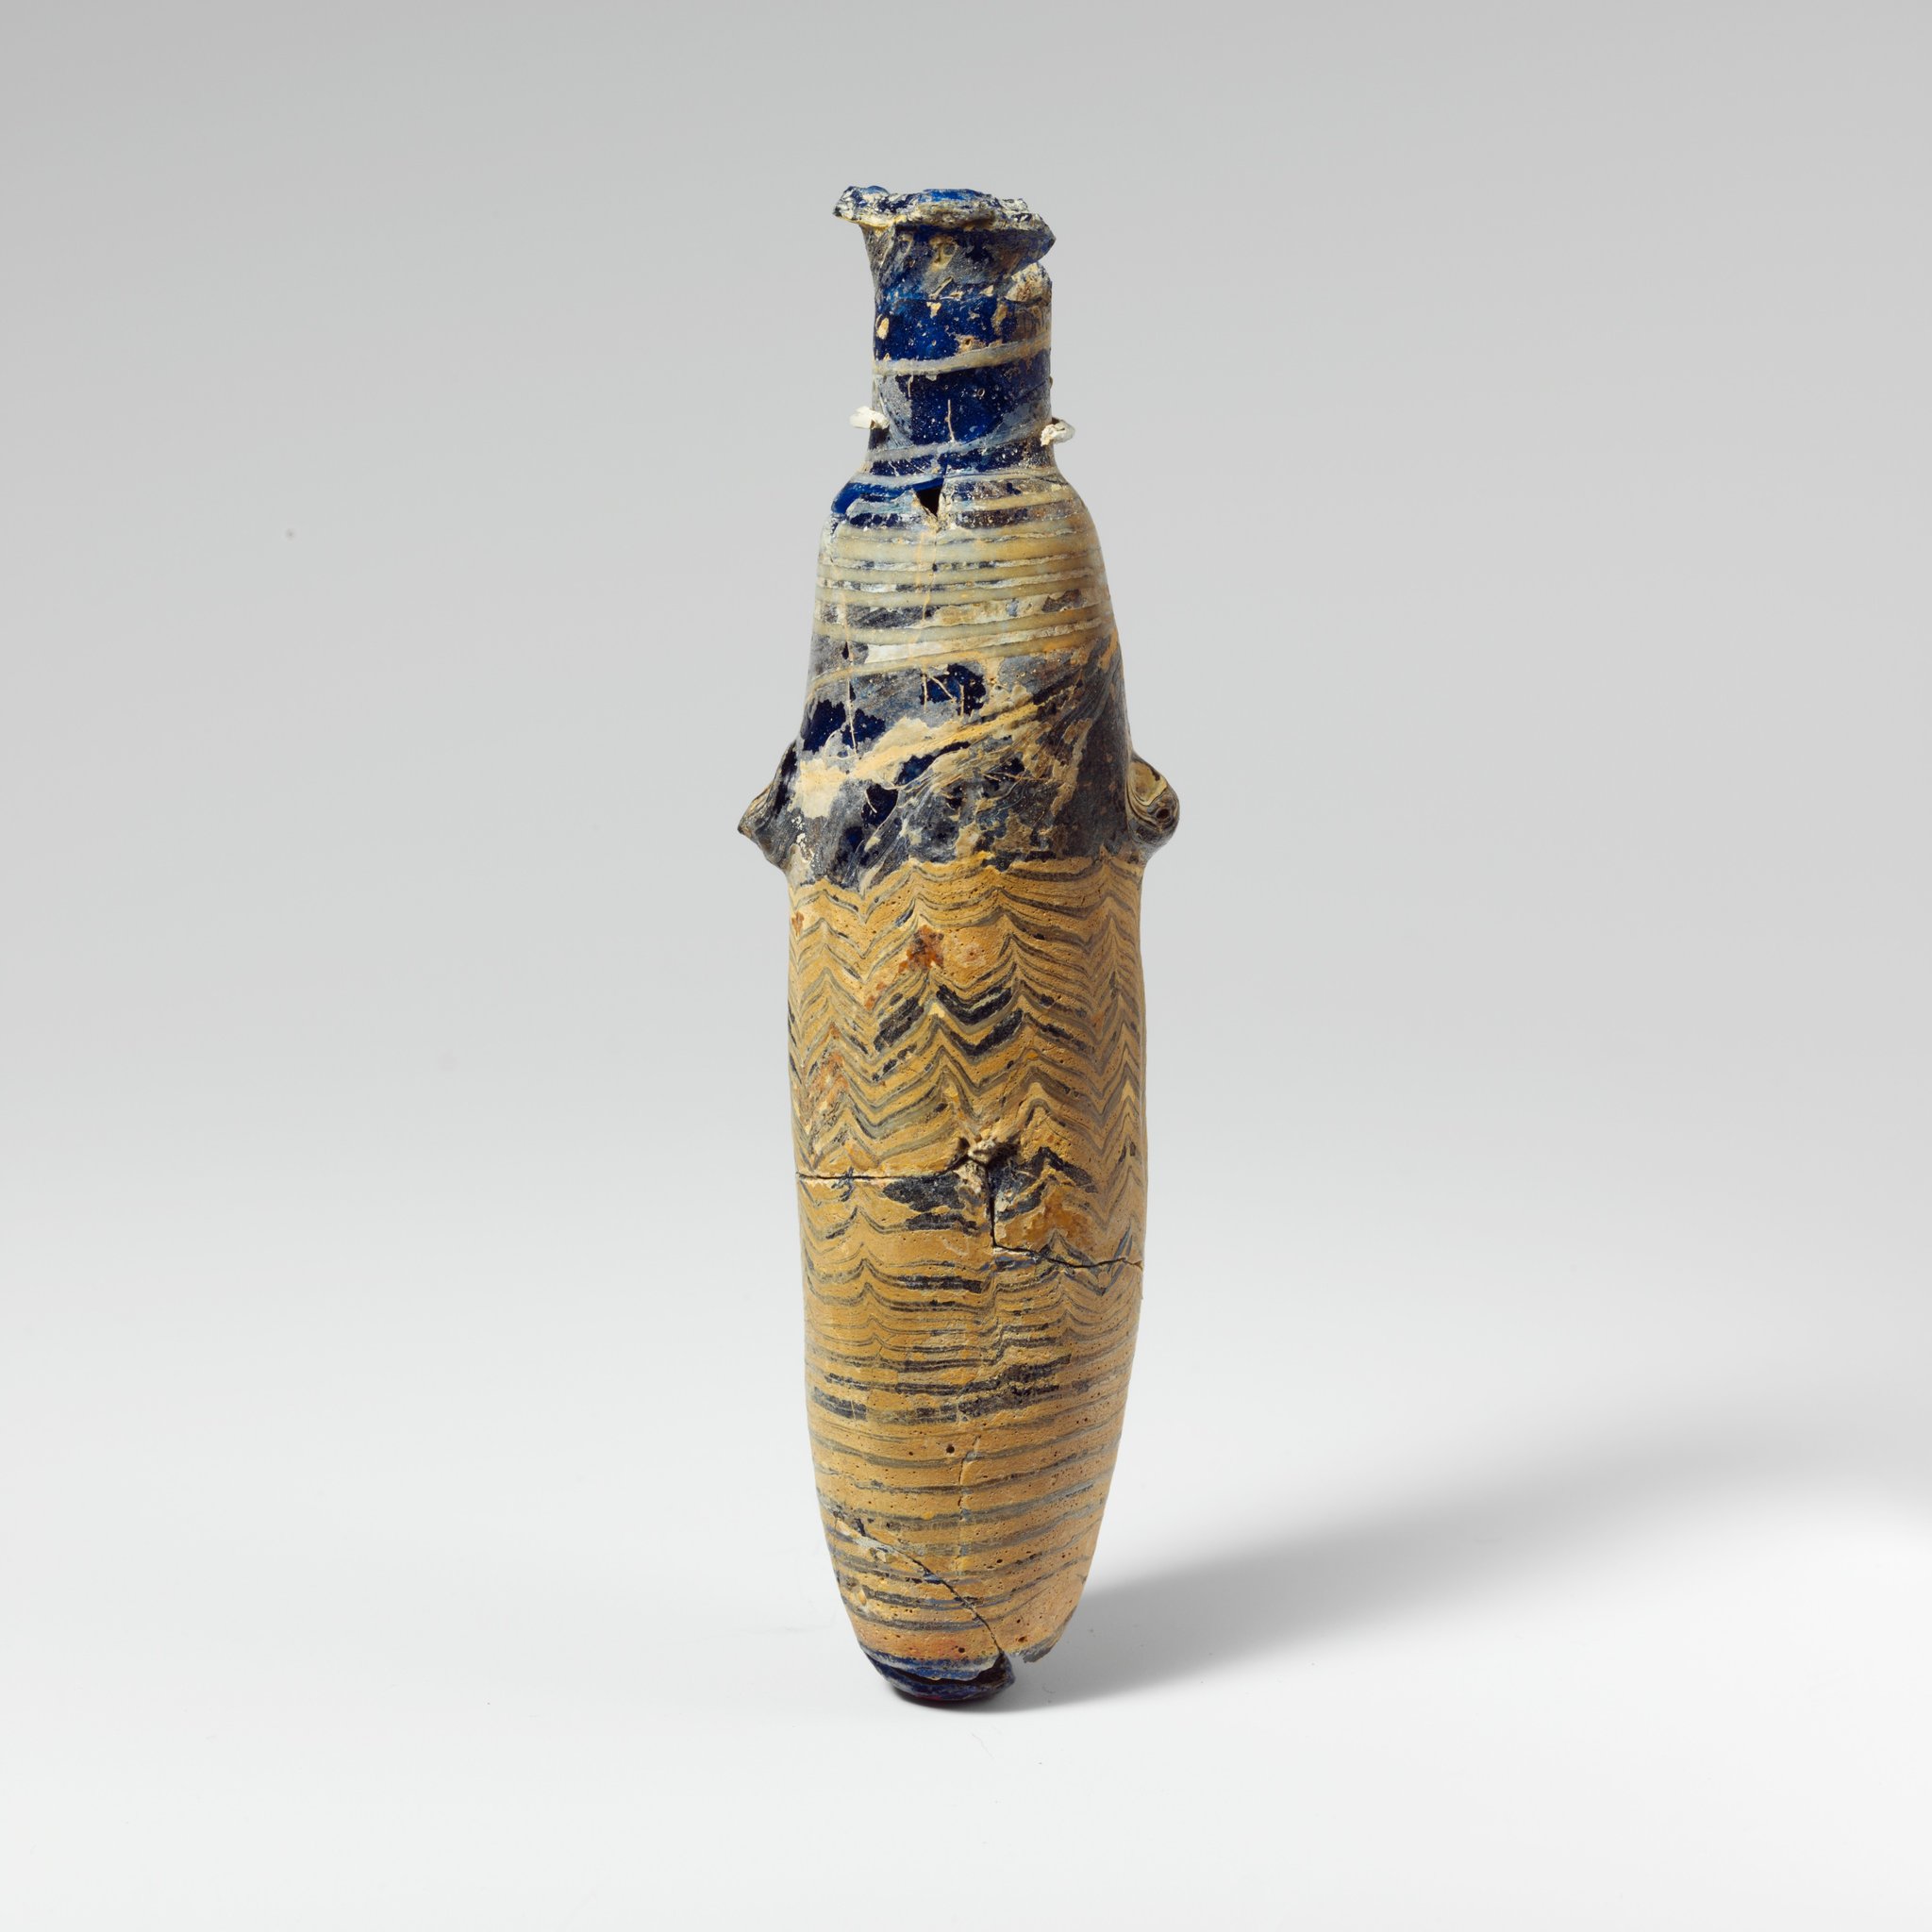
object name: alabastron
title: Glass alabastron (perfume bottle)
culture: greek or eastern mediterranean or italian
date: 367-268 BCE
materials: glass